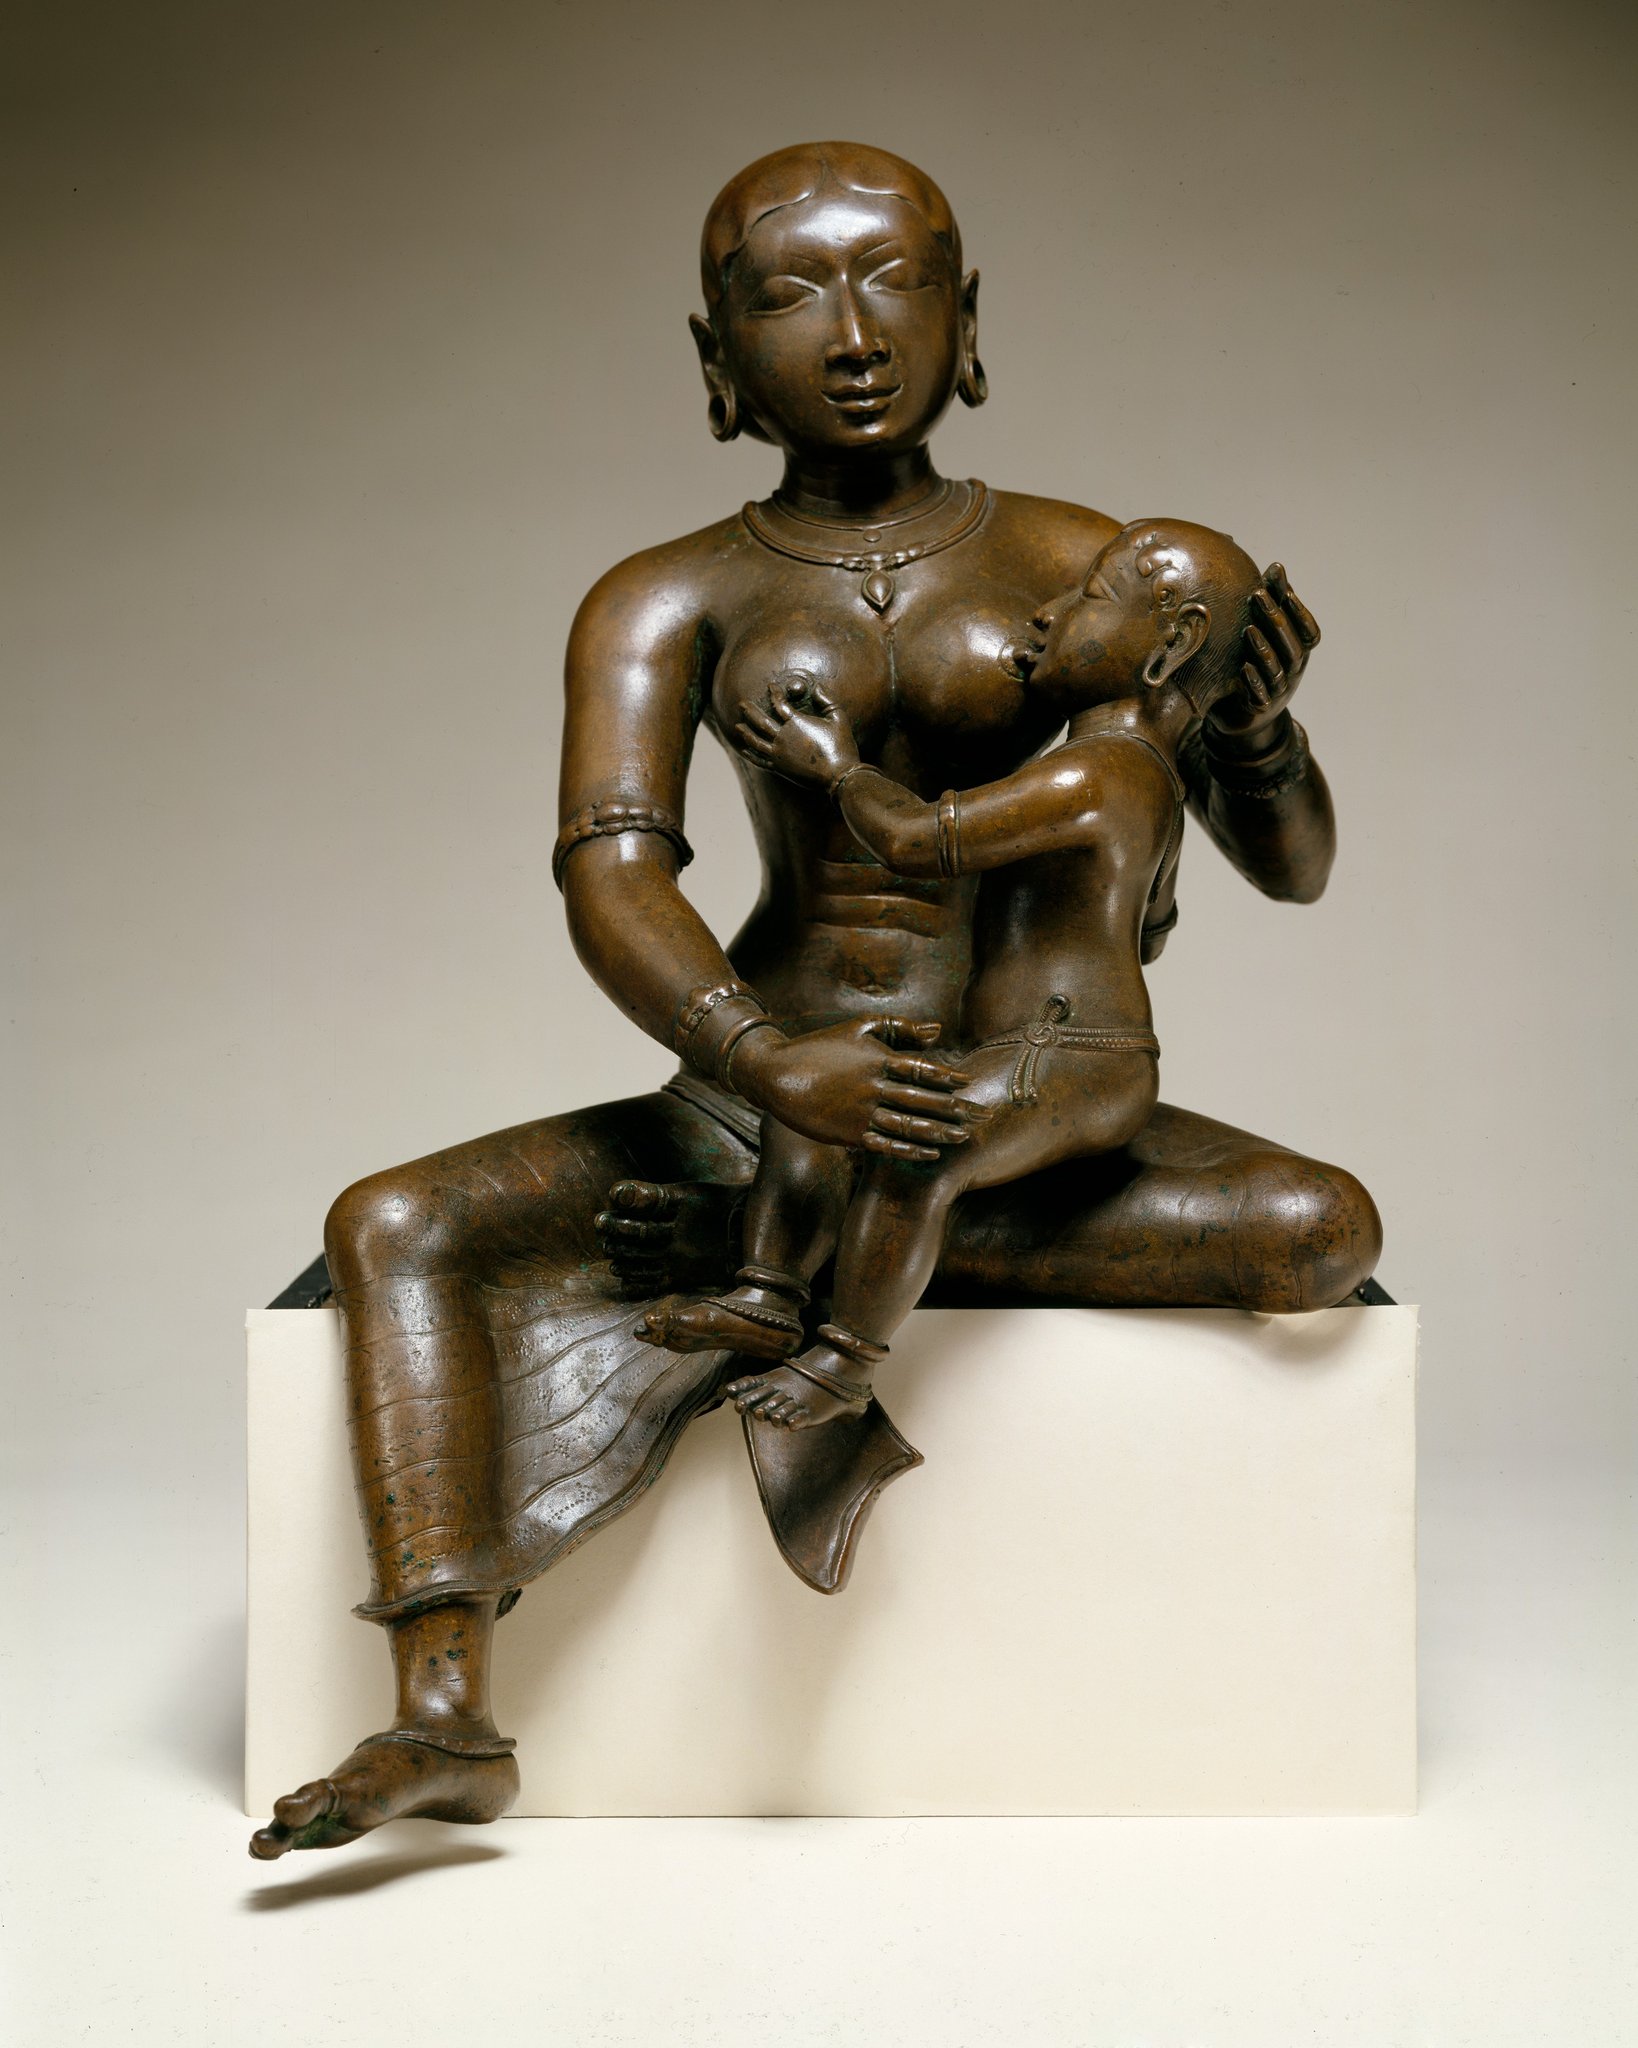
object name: figure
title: Yashoda with the Infant Krishna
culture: indian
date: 1101-1133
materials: copper alloy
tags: mothers,krishna,nursing